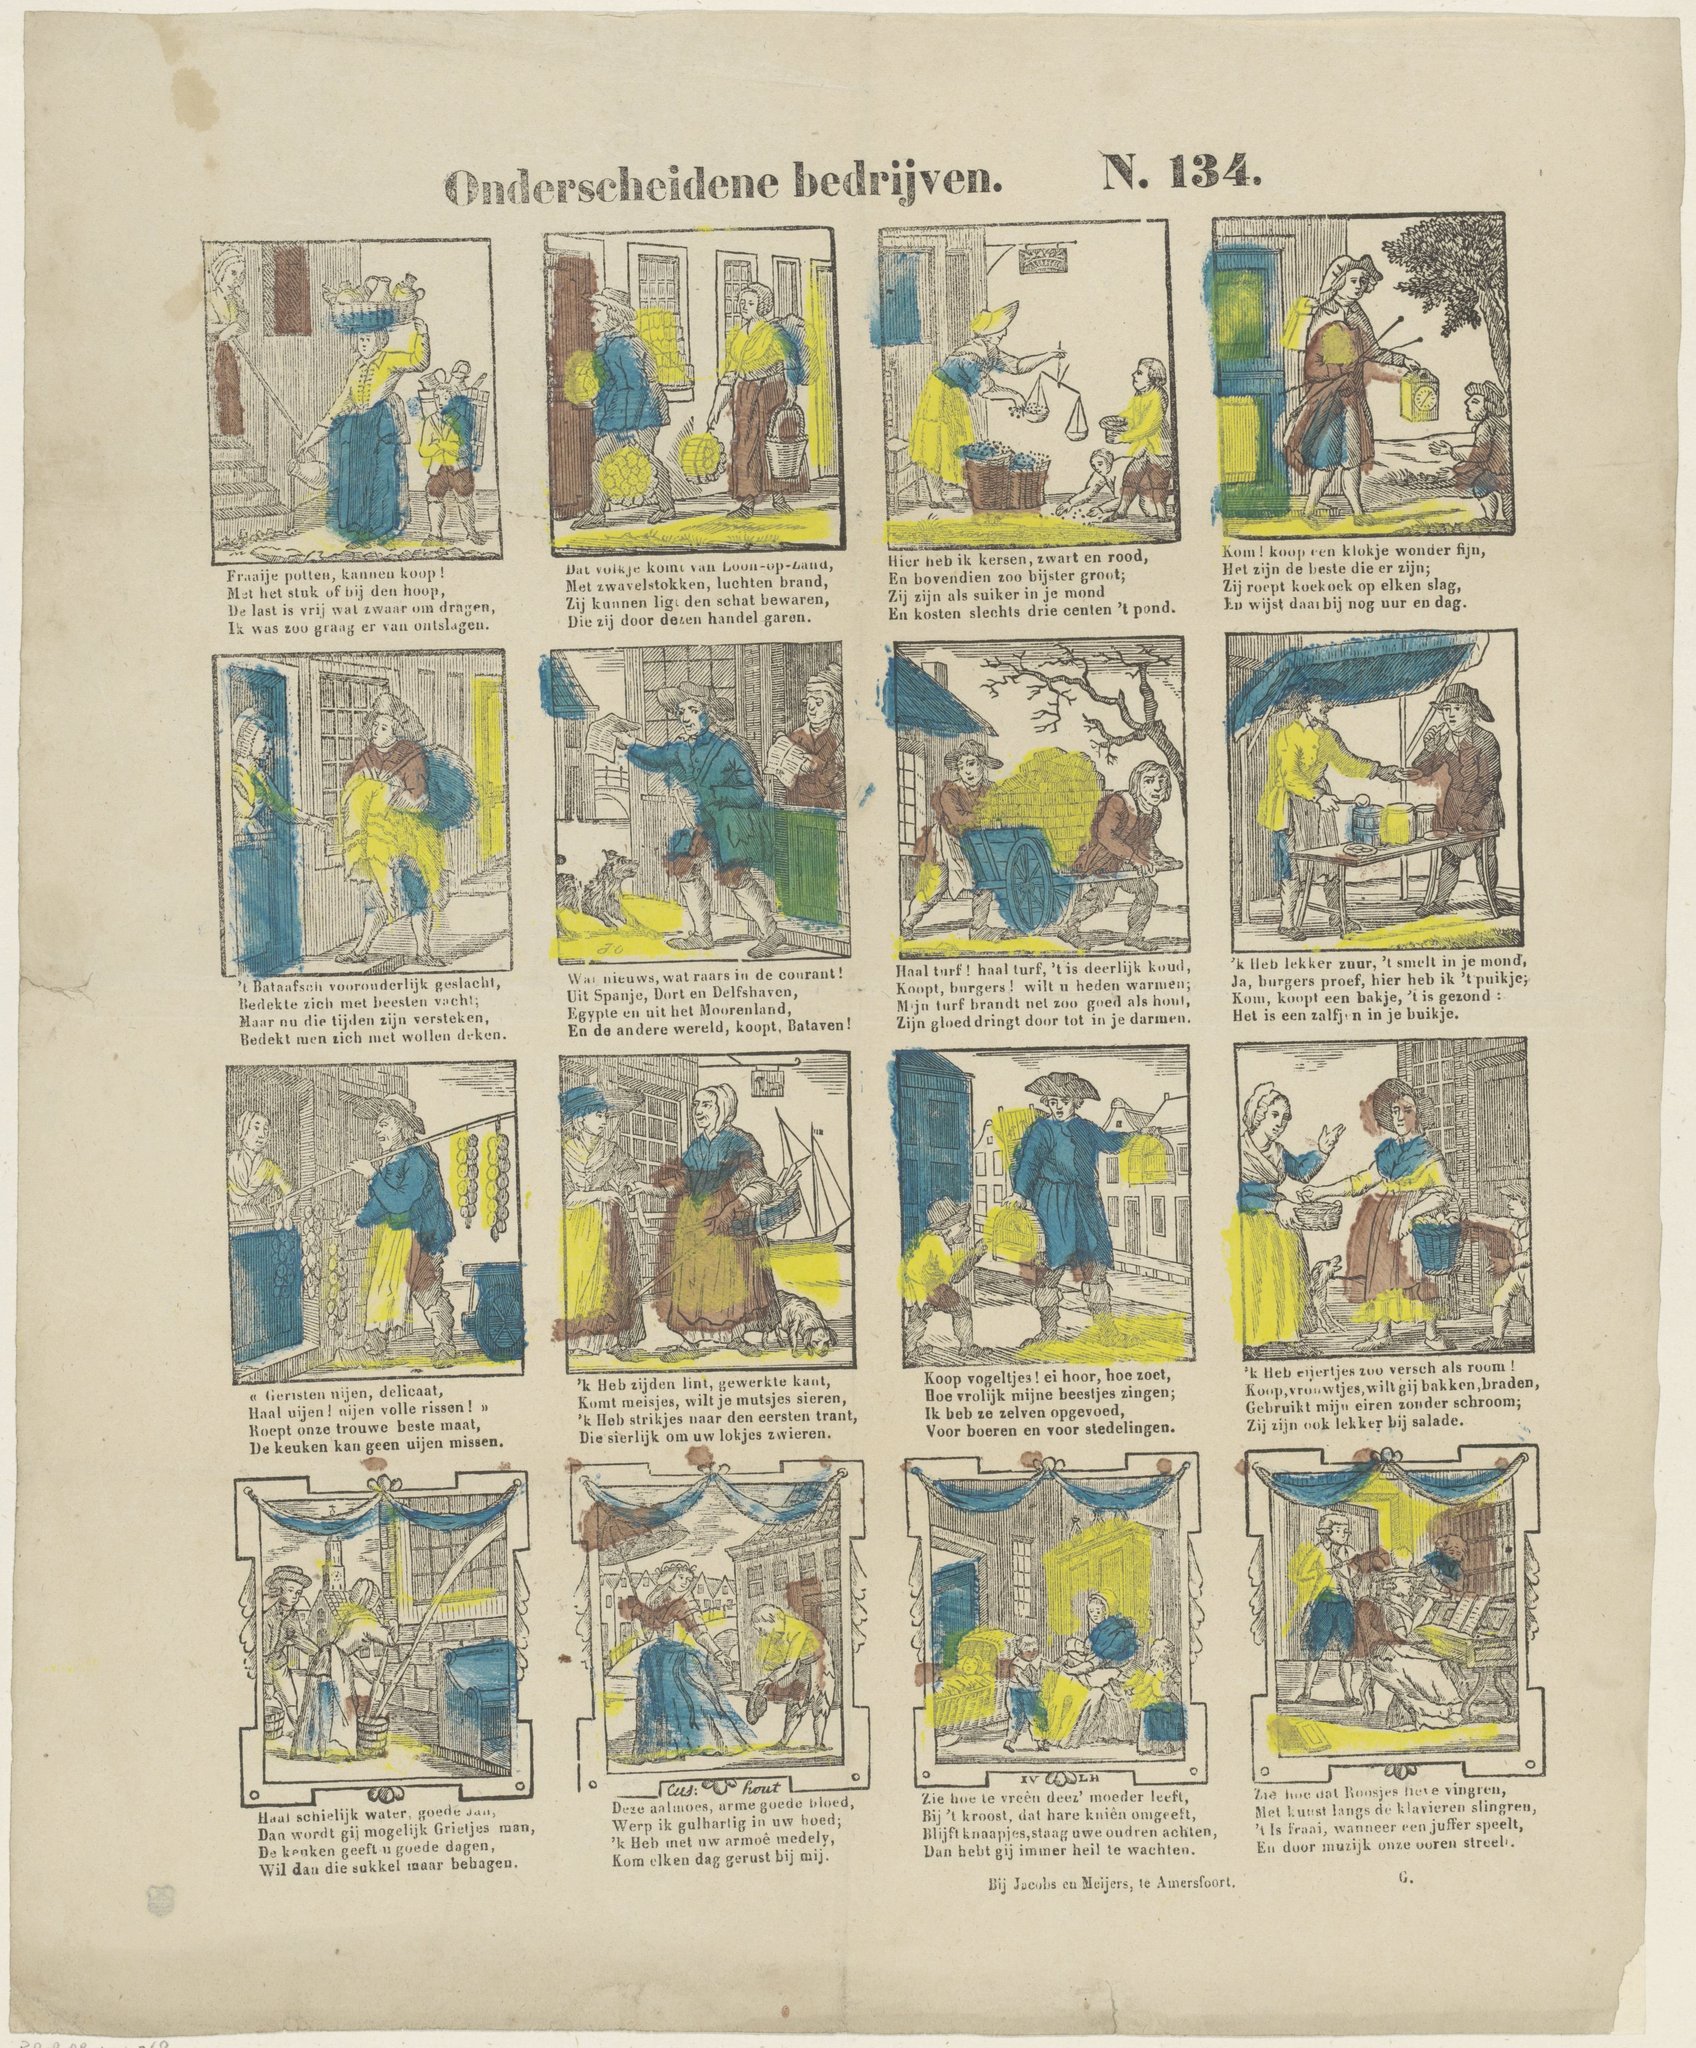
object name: popular print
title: Hoe zich 't kleine volkje weert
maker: Anonymous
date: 1874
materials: paper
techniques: lithograph, letterpress printing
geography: amsterdam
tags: child, parental love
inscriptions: collector's mark: Lugt 2760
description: Blad met 6 voorstellingen van kinderen, waaronder een meisje met zwarte handen, een kind met een duif, een slapende moeder met kind en twee kinderen met vaders stok en laarzen. Onder elke afbeelding een vierregelig vers in twee kolommen. Genummerd rechtsboven: No. 38.